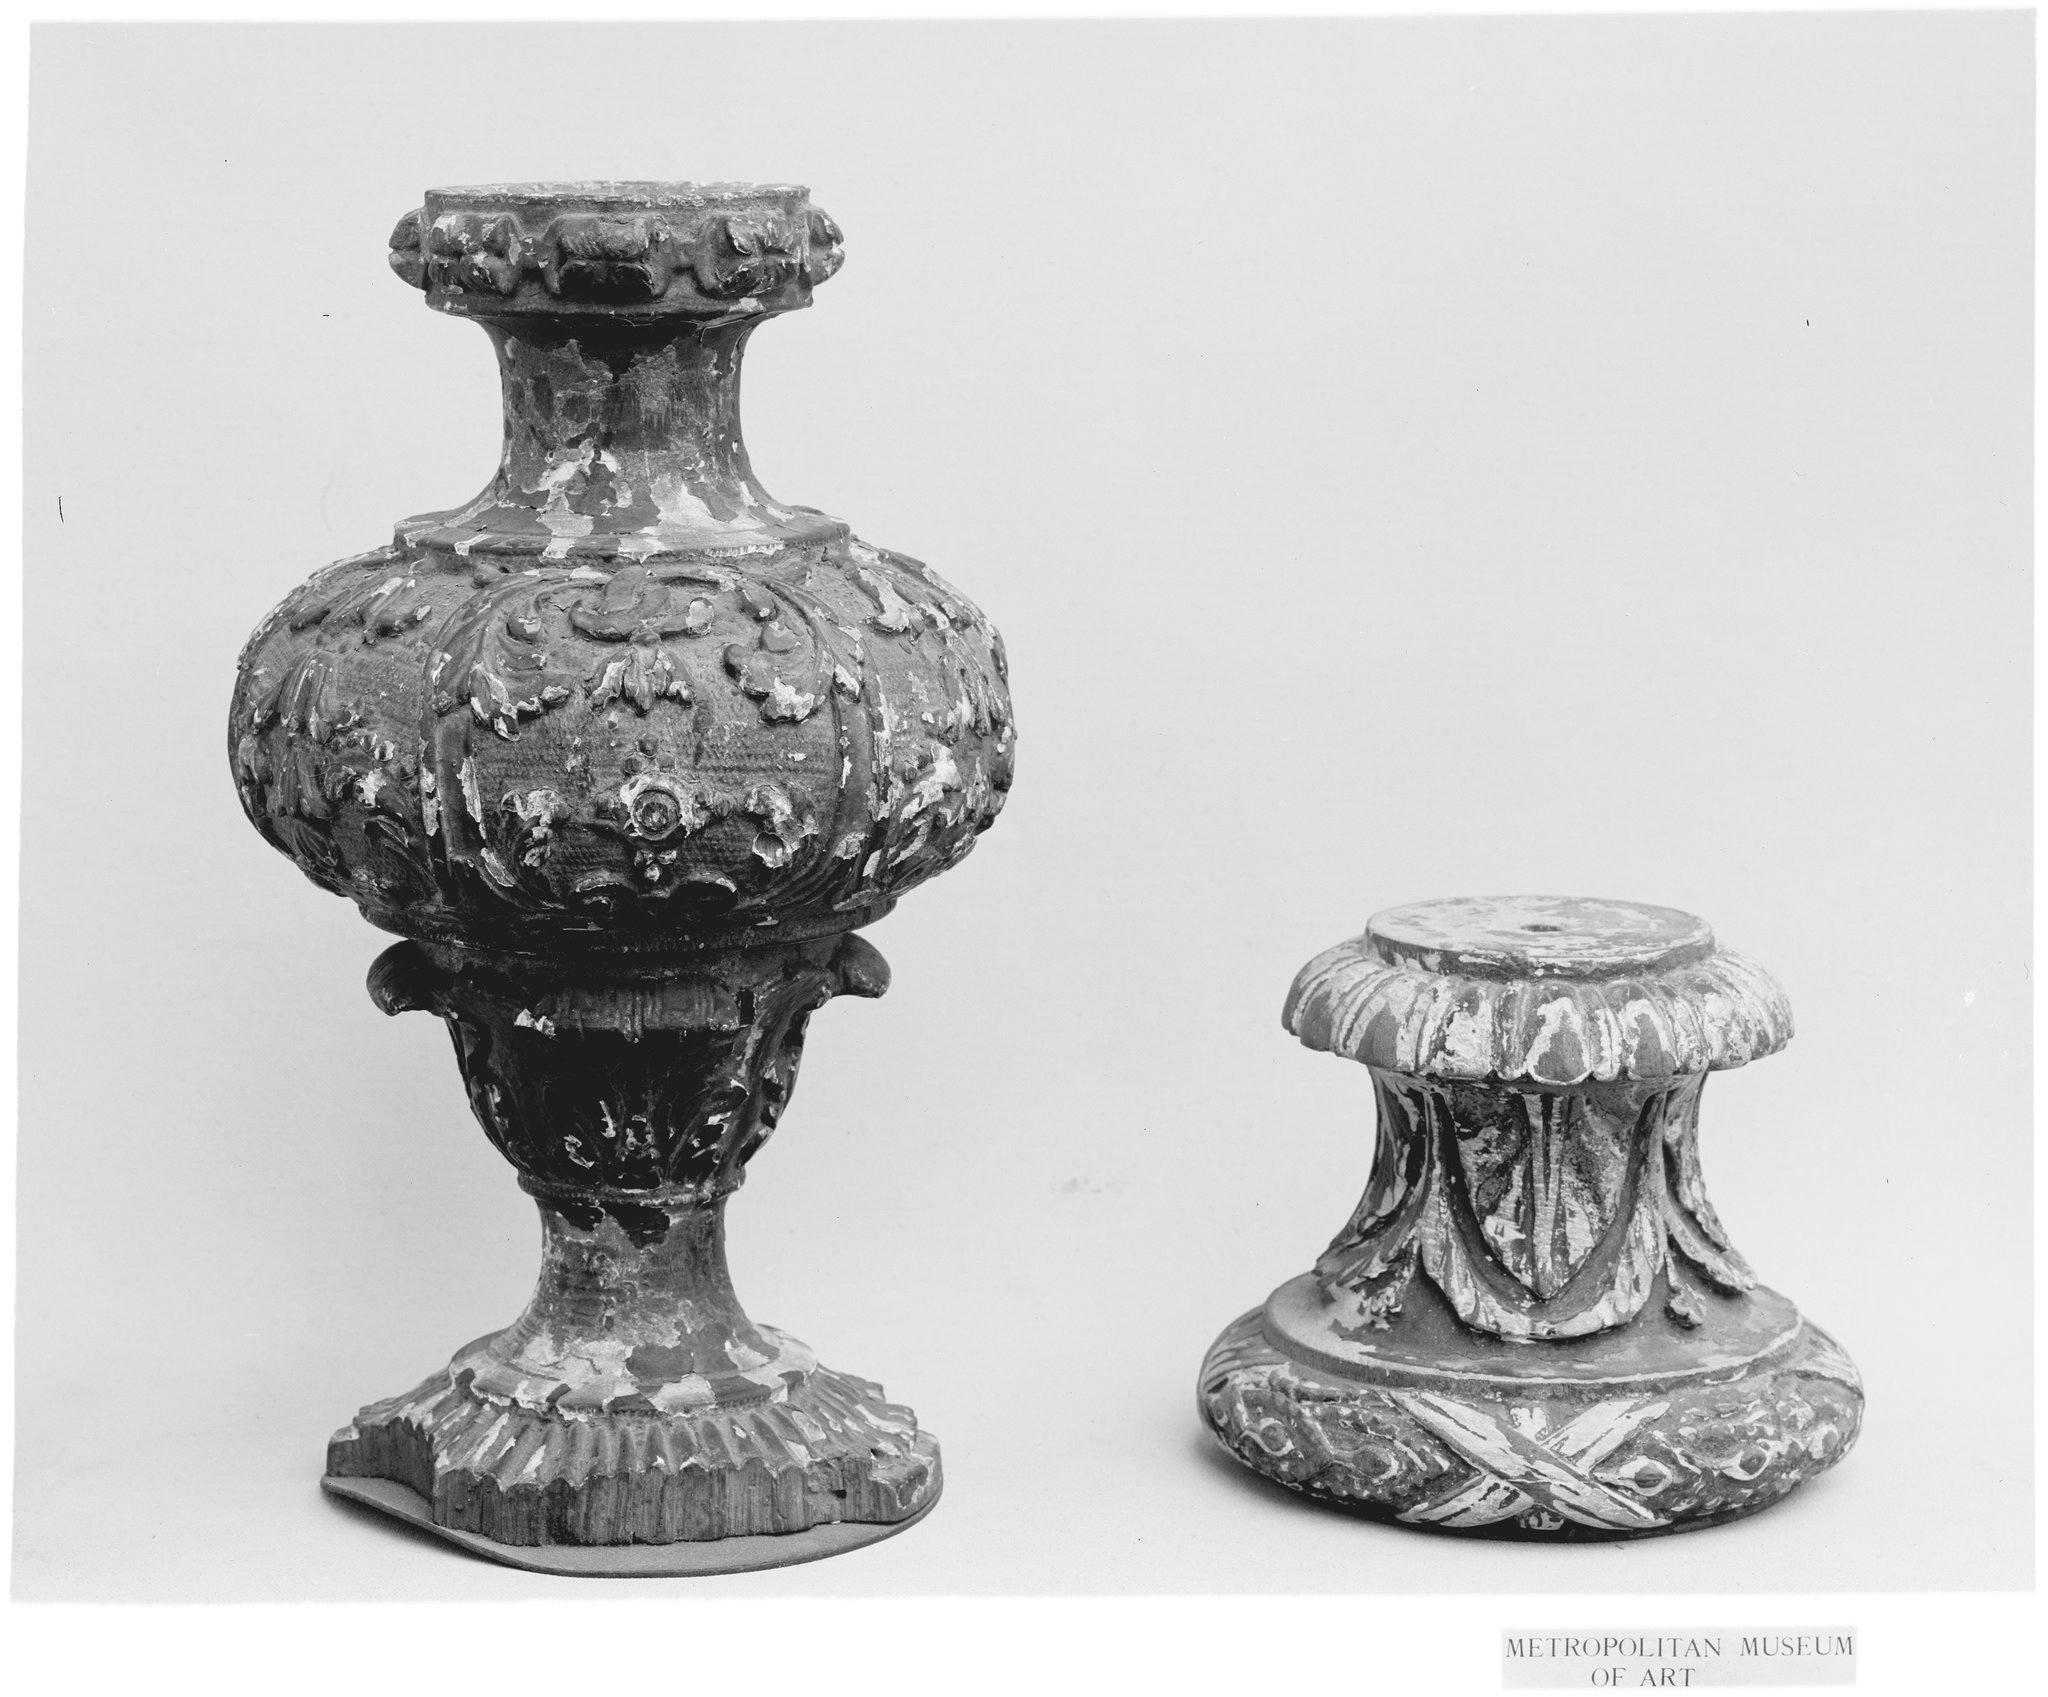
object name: vase ornament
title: Vase ornament for console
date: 1701-1725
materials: wood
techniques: carving, gilding